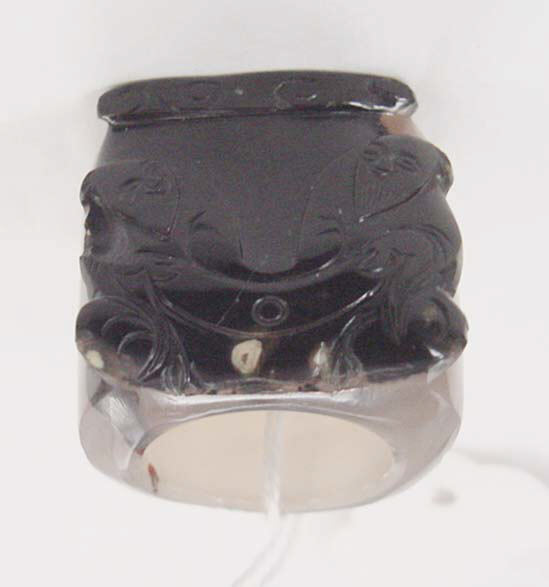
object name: ring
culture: chinese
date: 1801-1900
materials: jade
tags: men